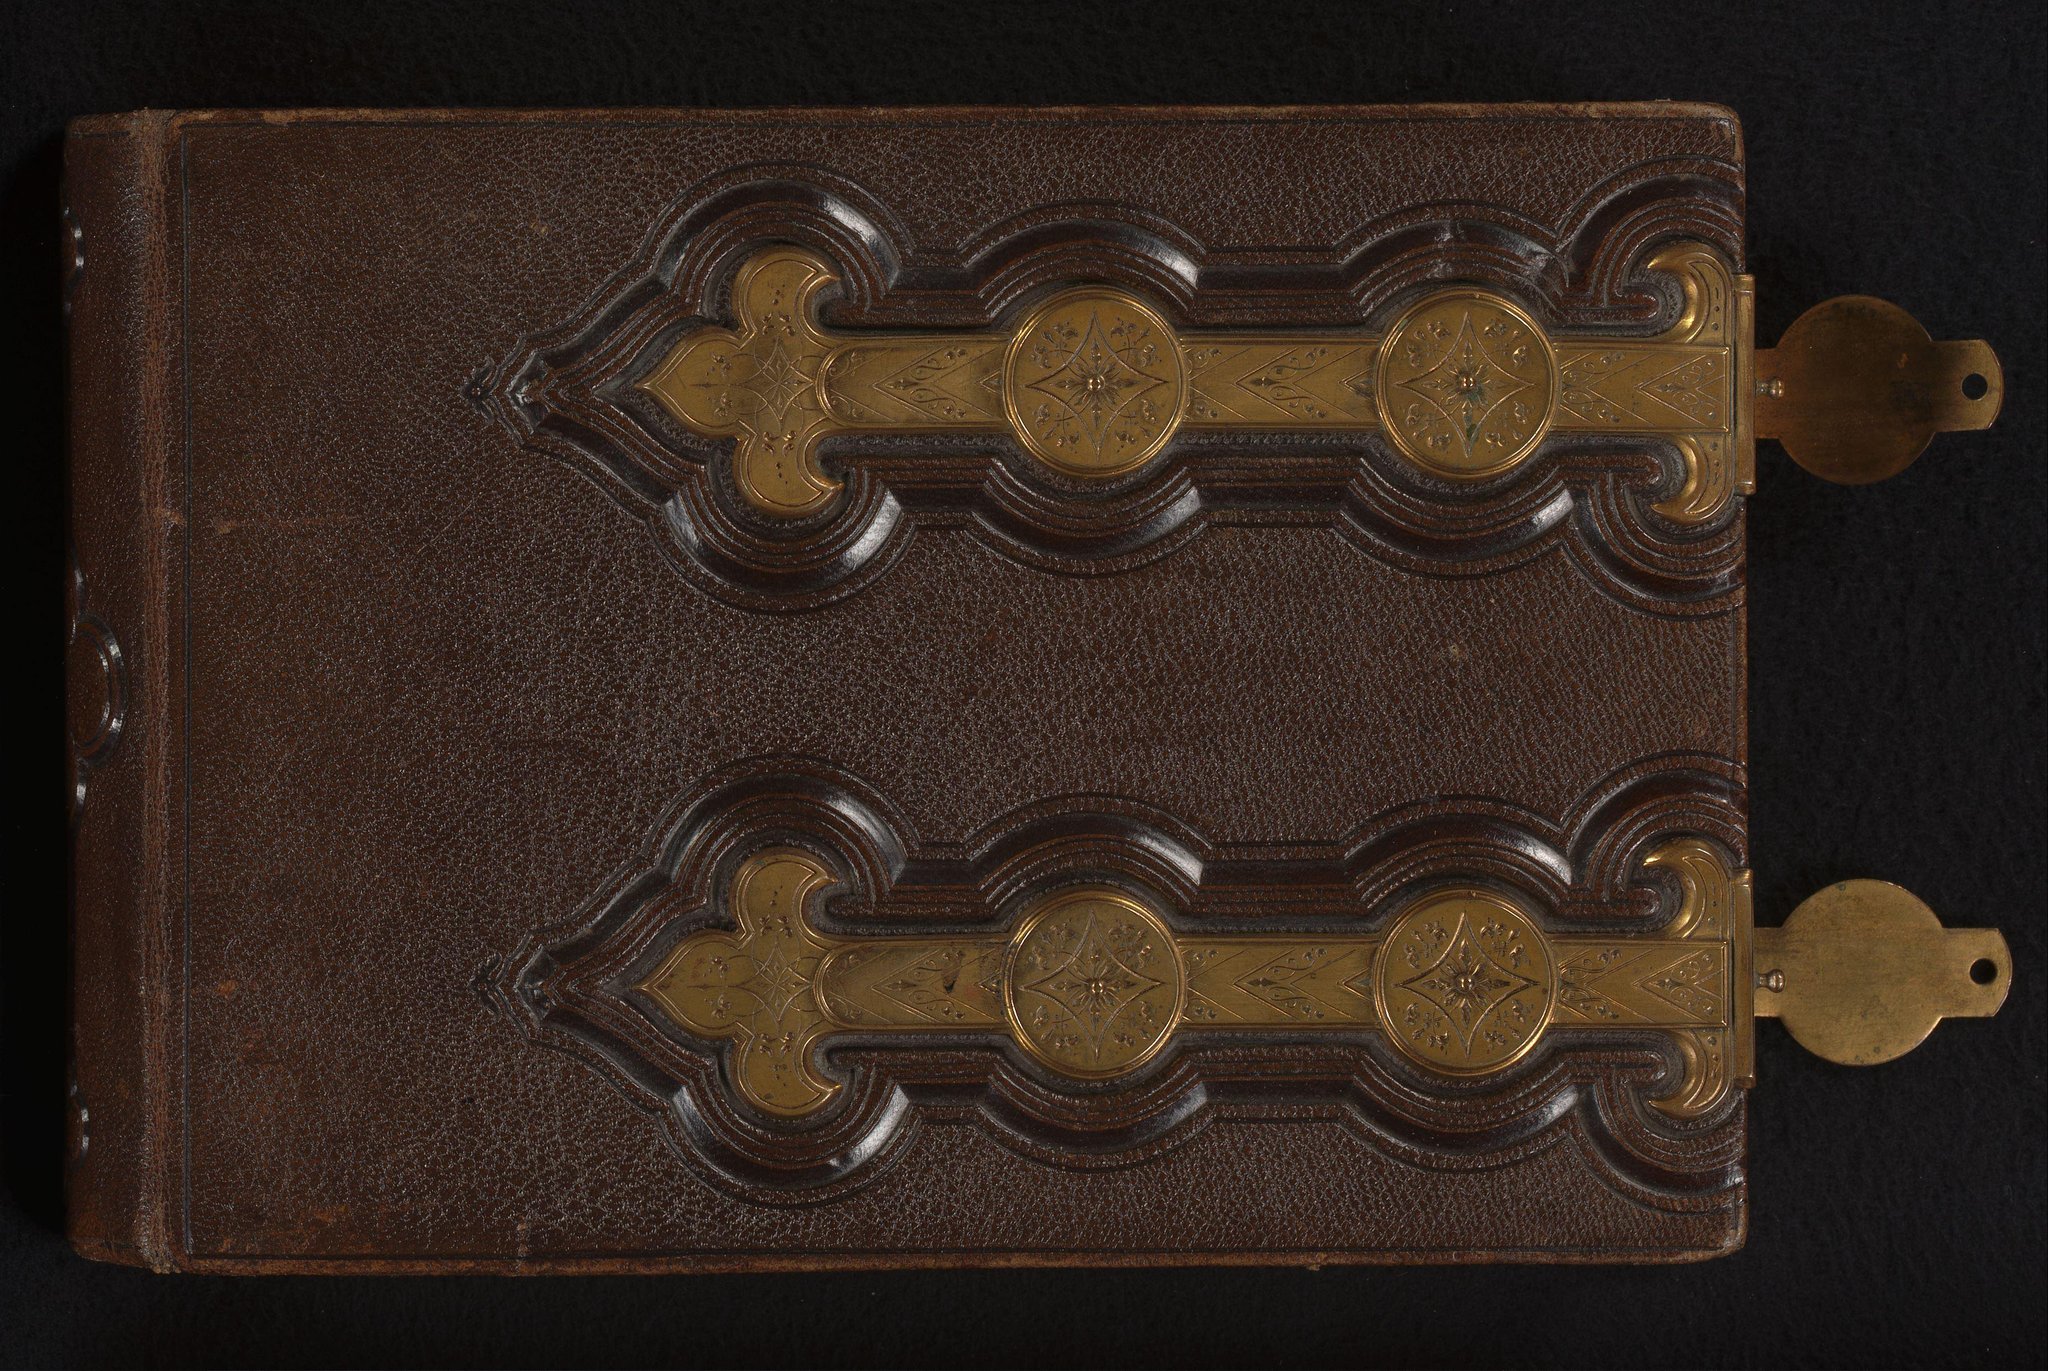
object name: slip in album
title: Fotoalbum (leeg)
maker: Anonymous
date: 1860-1900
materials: cardboard, leather, metal, paper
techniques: color on snow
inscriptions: collector's mark: ‘DIENST/ VERSPREIDE/ RIJKSKOLLEKTIES/ (...) A 888’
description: Fotoalbum met veertig pagina's met op iedere pagina naast elkaar twee met gouden lijnen omkaderde passe-partouts voor cartes-de-visite. Onder iedere passe-partout staat de afkorting "A. L. Bté S. G. D. G." vermeld.